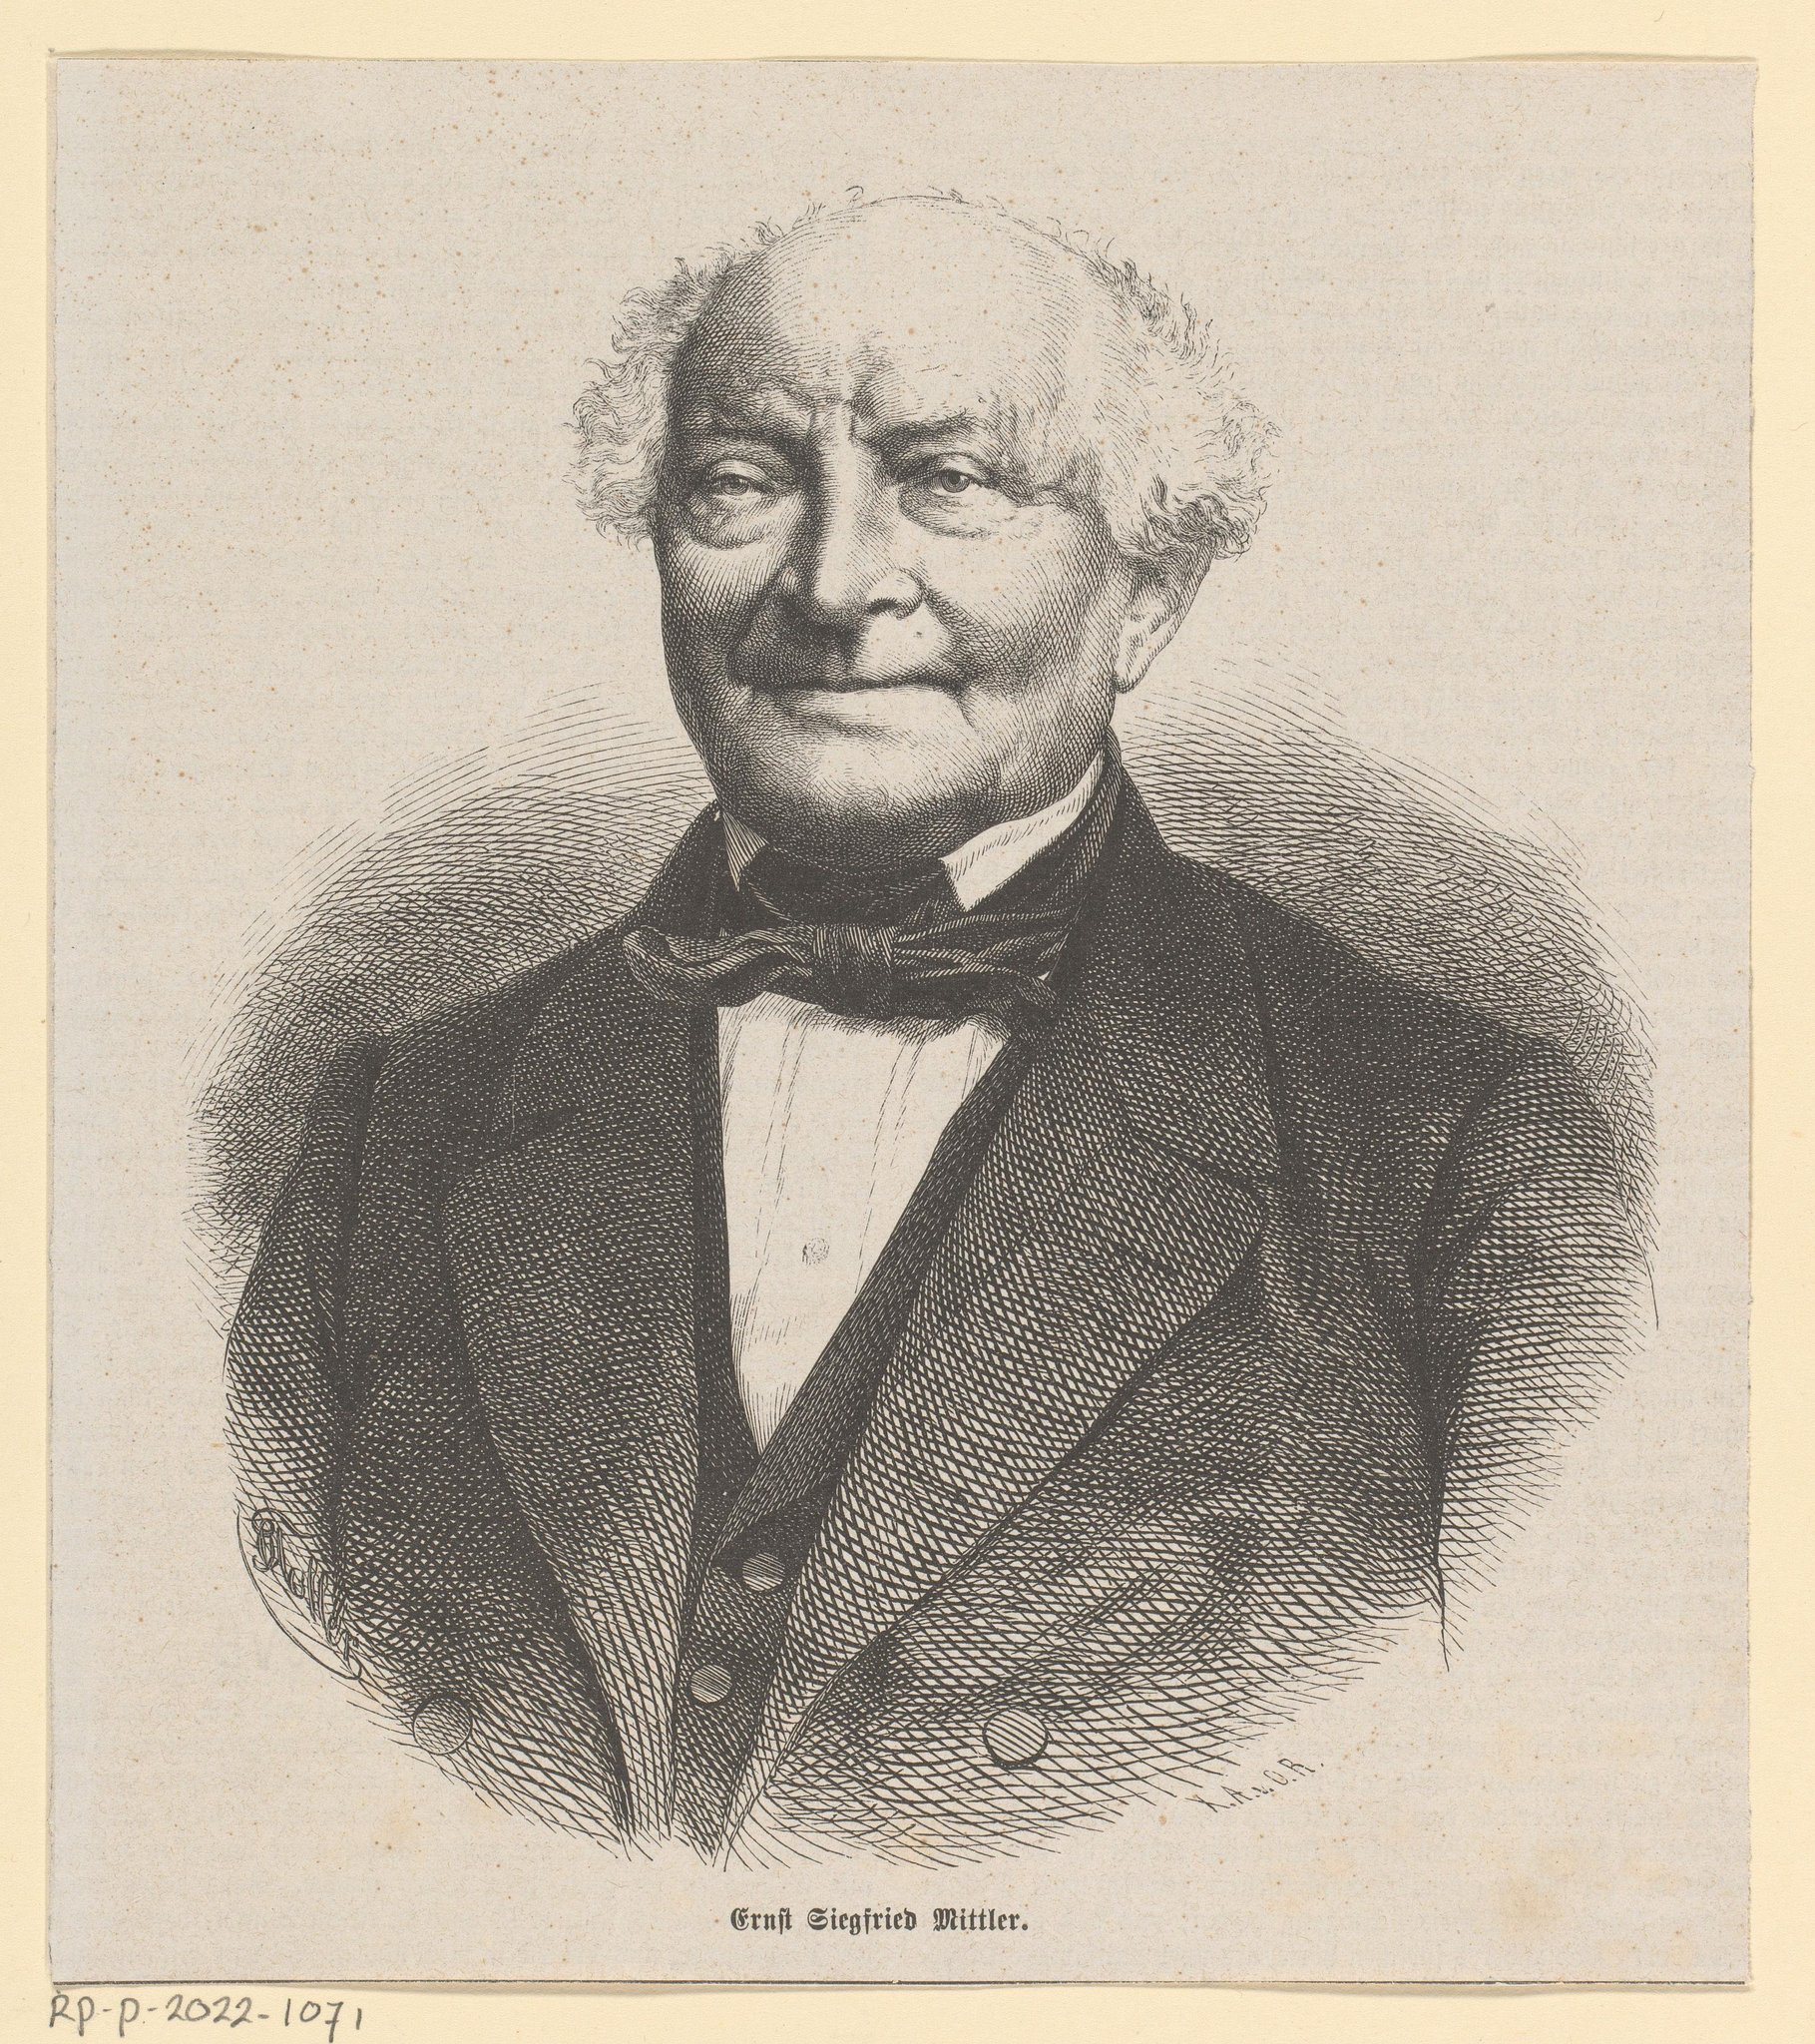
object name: print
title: Portret van Ernst Siegfried Mittler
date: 1820-1900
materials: paper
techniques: letterpress printing, engraving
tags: berlin, publisher, historical persons, publishing, publisher